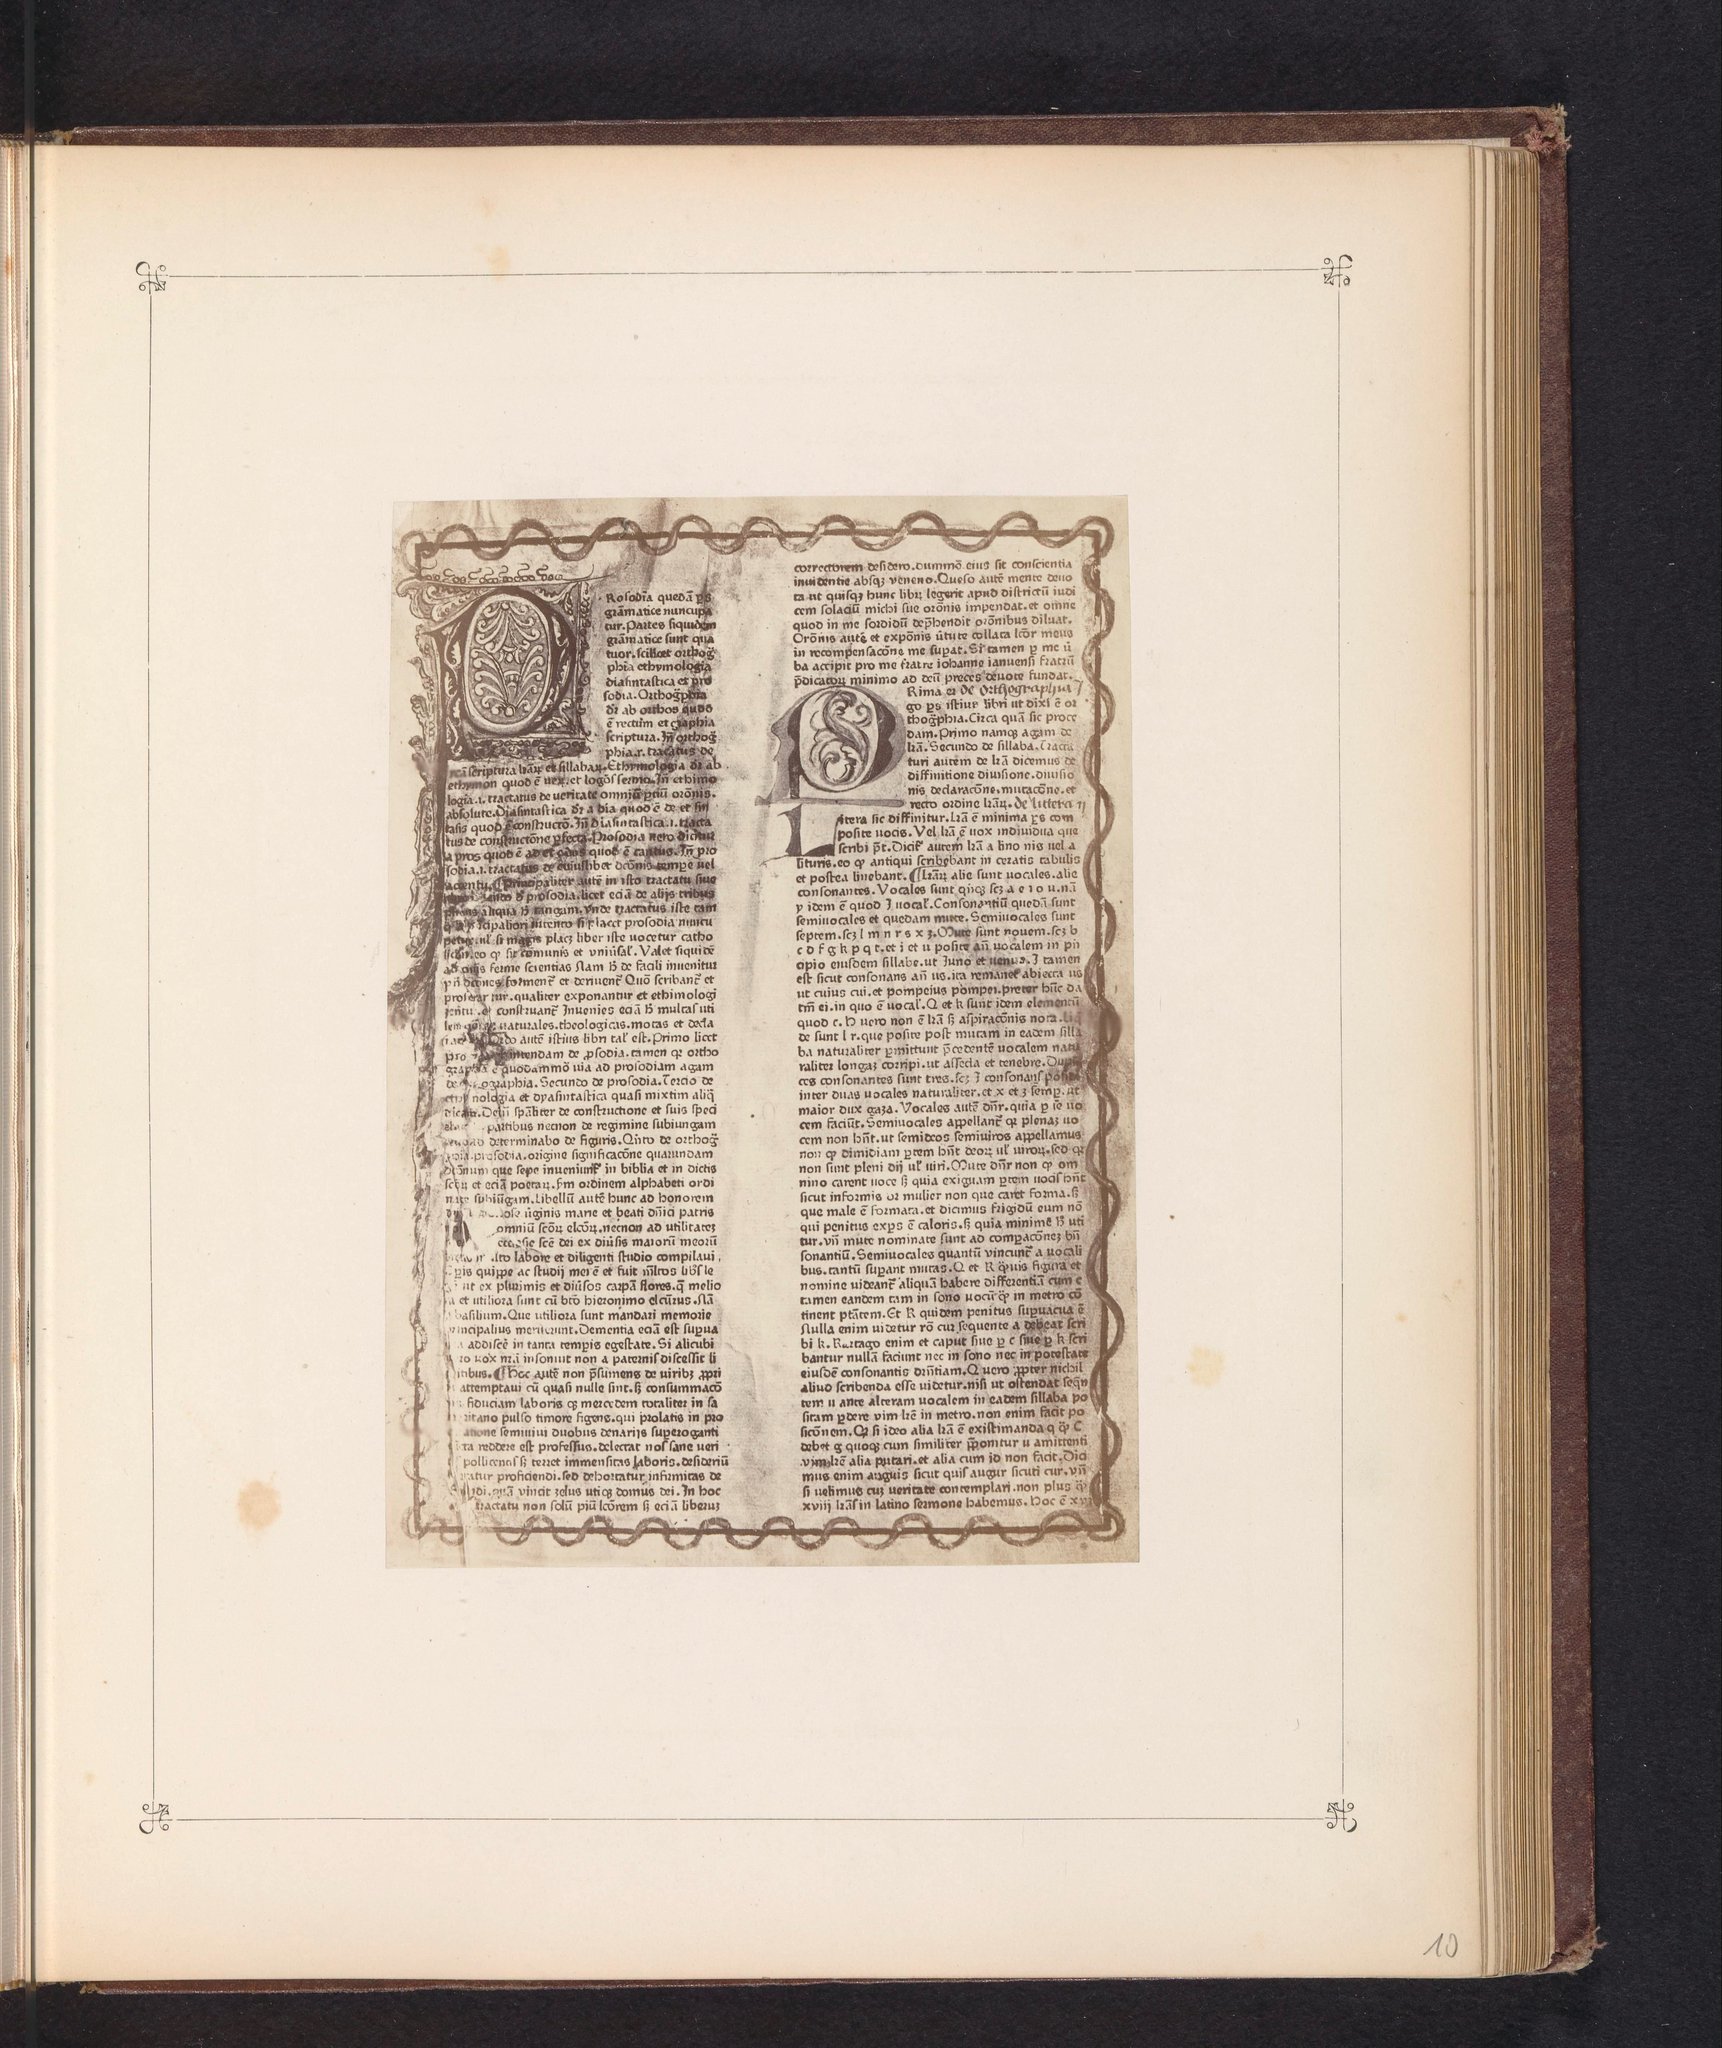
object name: page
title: Fotoreproductie van de eerste pagina van de Catholicon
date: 1867-1872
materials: photographic support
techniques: albumen print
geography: mainz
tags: book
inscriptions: number: ‘10’